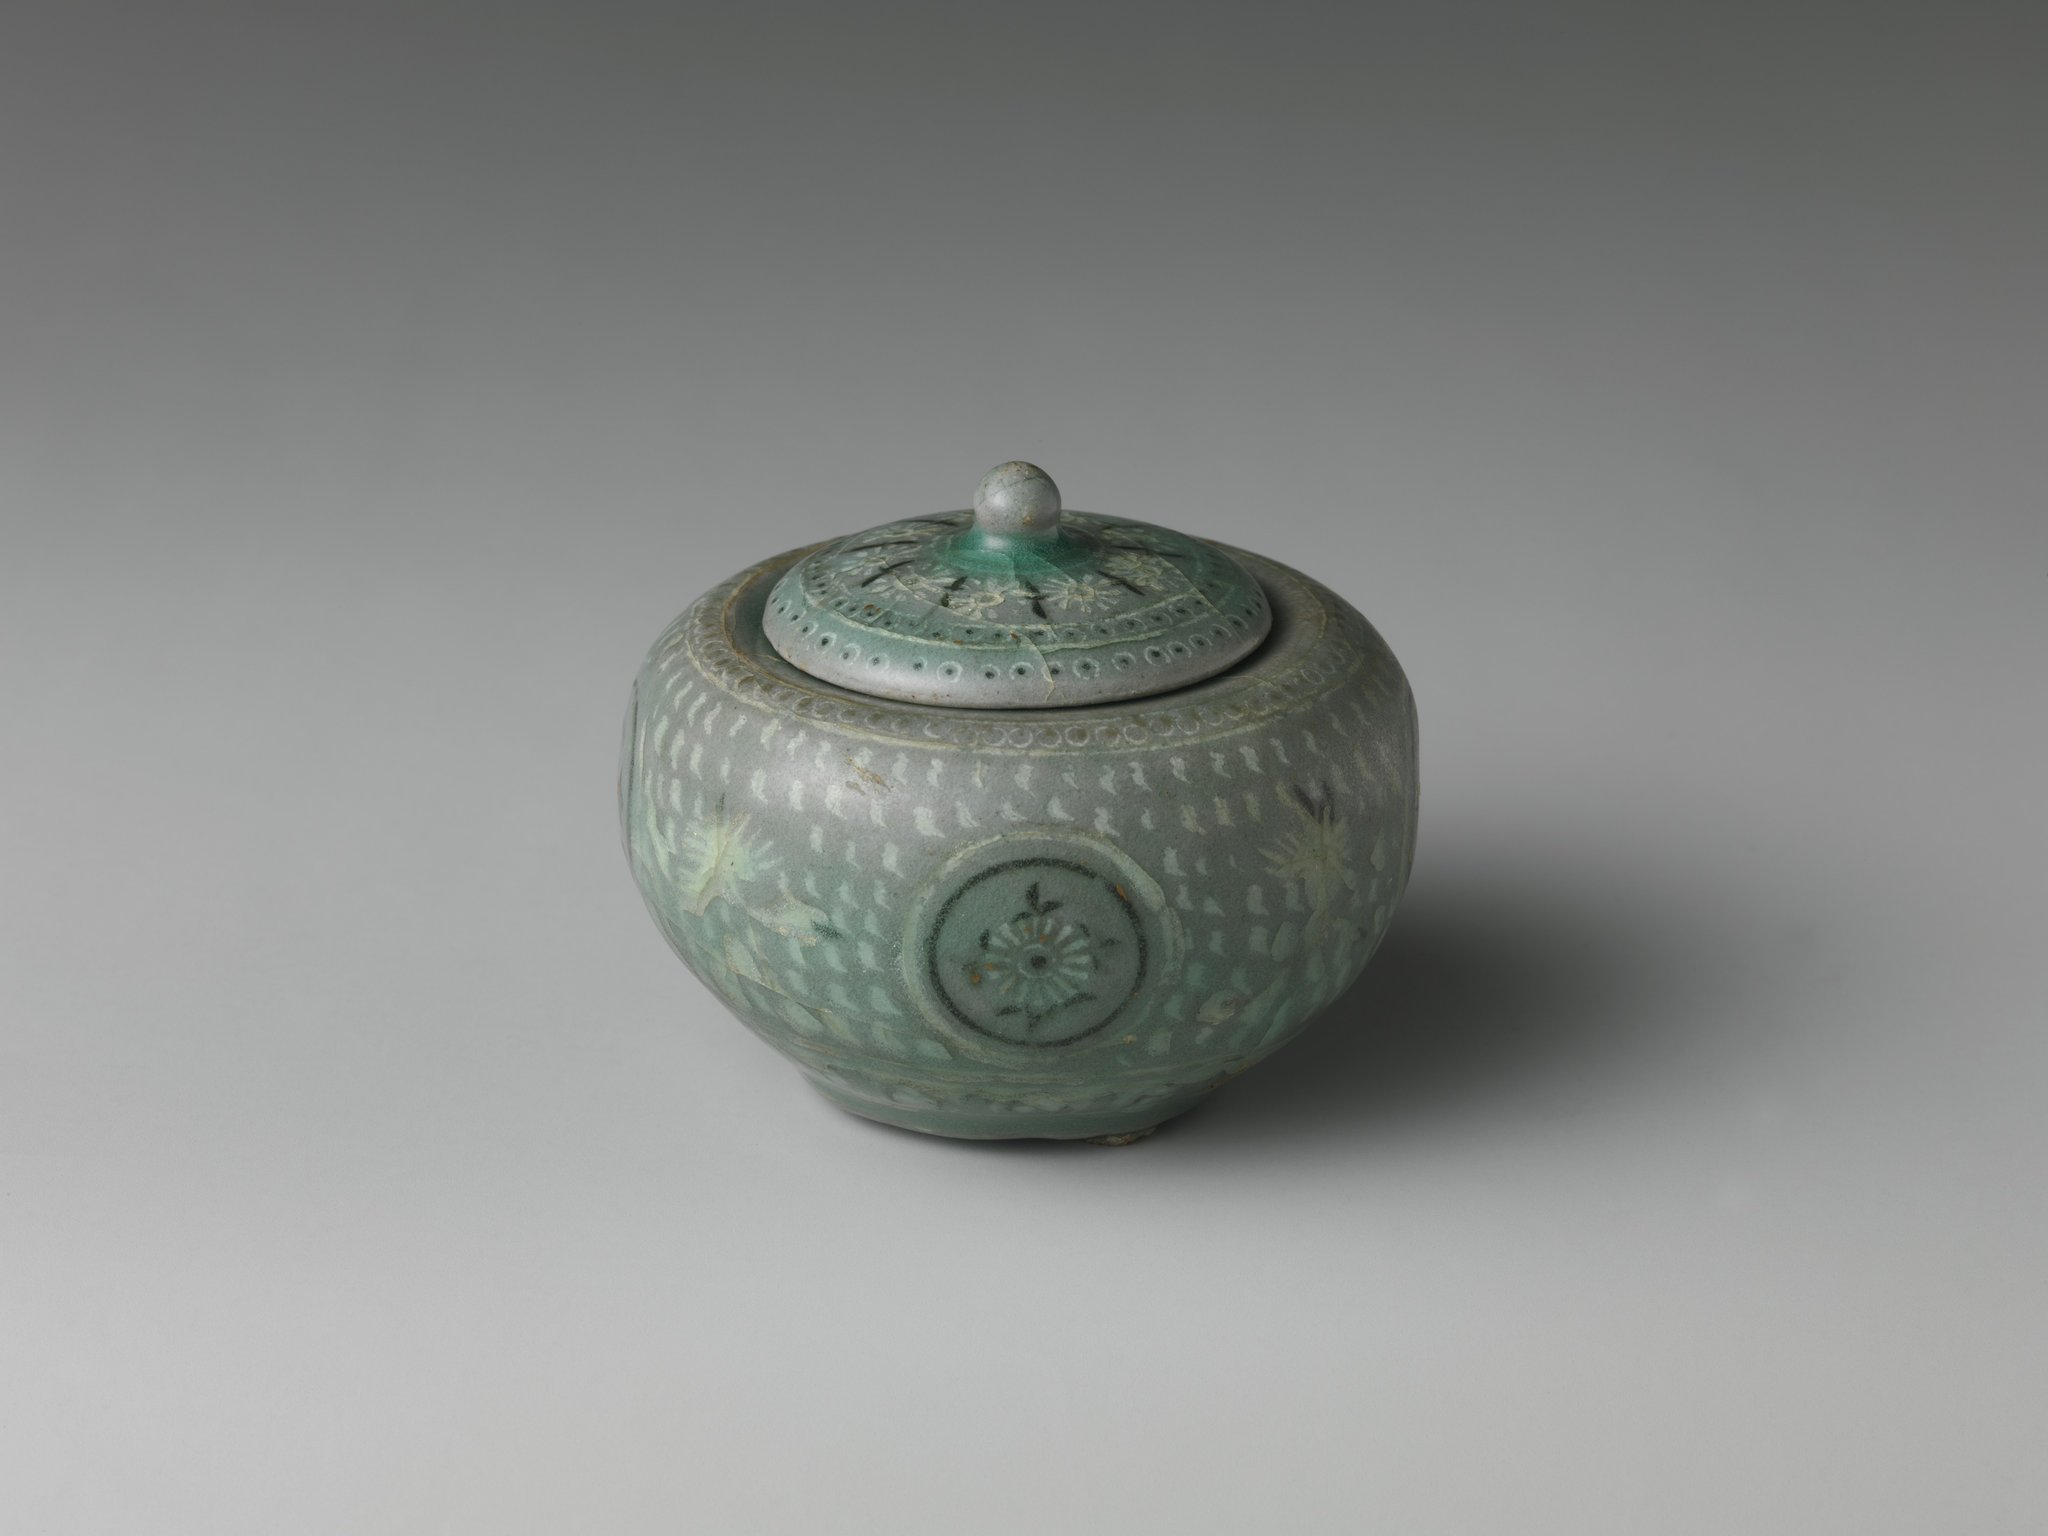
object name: jar with cover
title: Small jar and cover decorated with chrysanthemums, cranes, and clouds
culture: korean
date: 1267-1300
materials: ceramic glaze, glaze, gold, stoneware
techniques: inlay